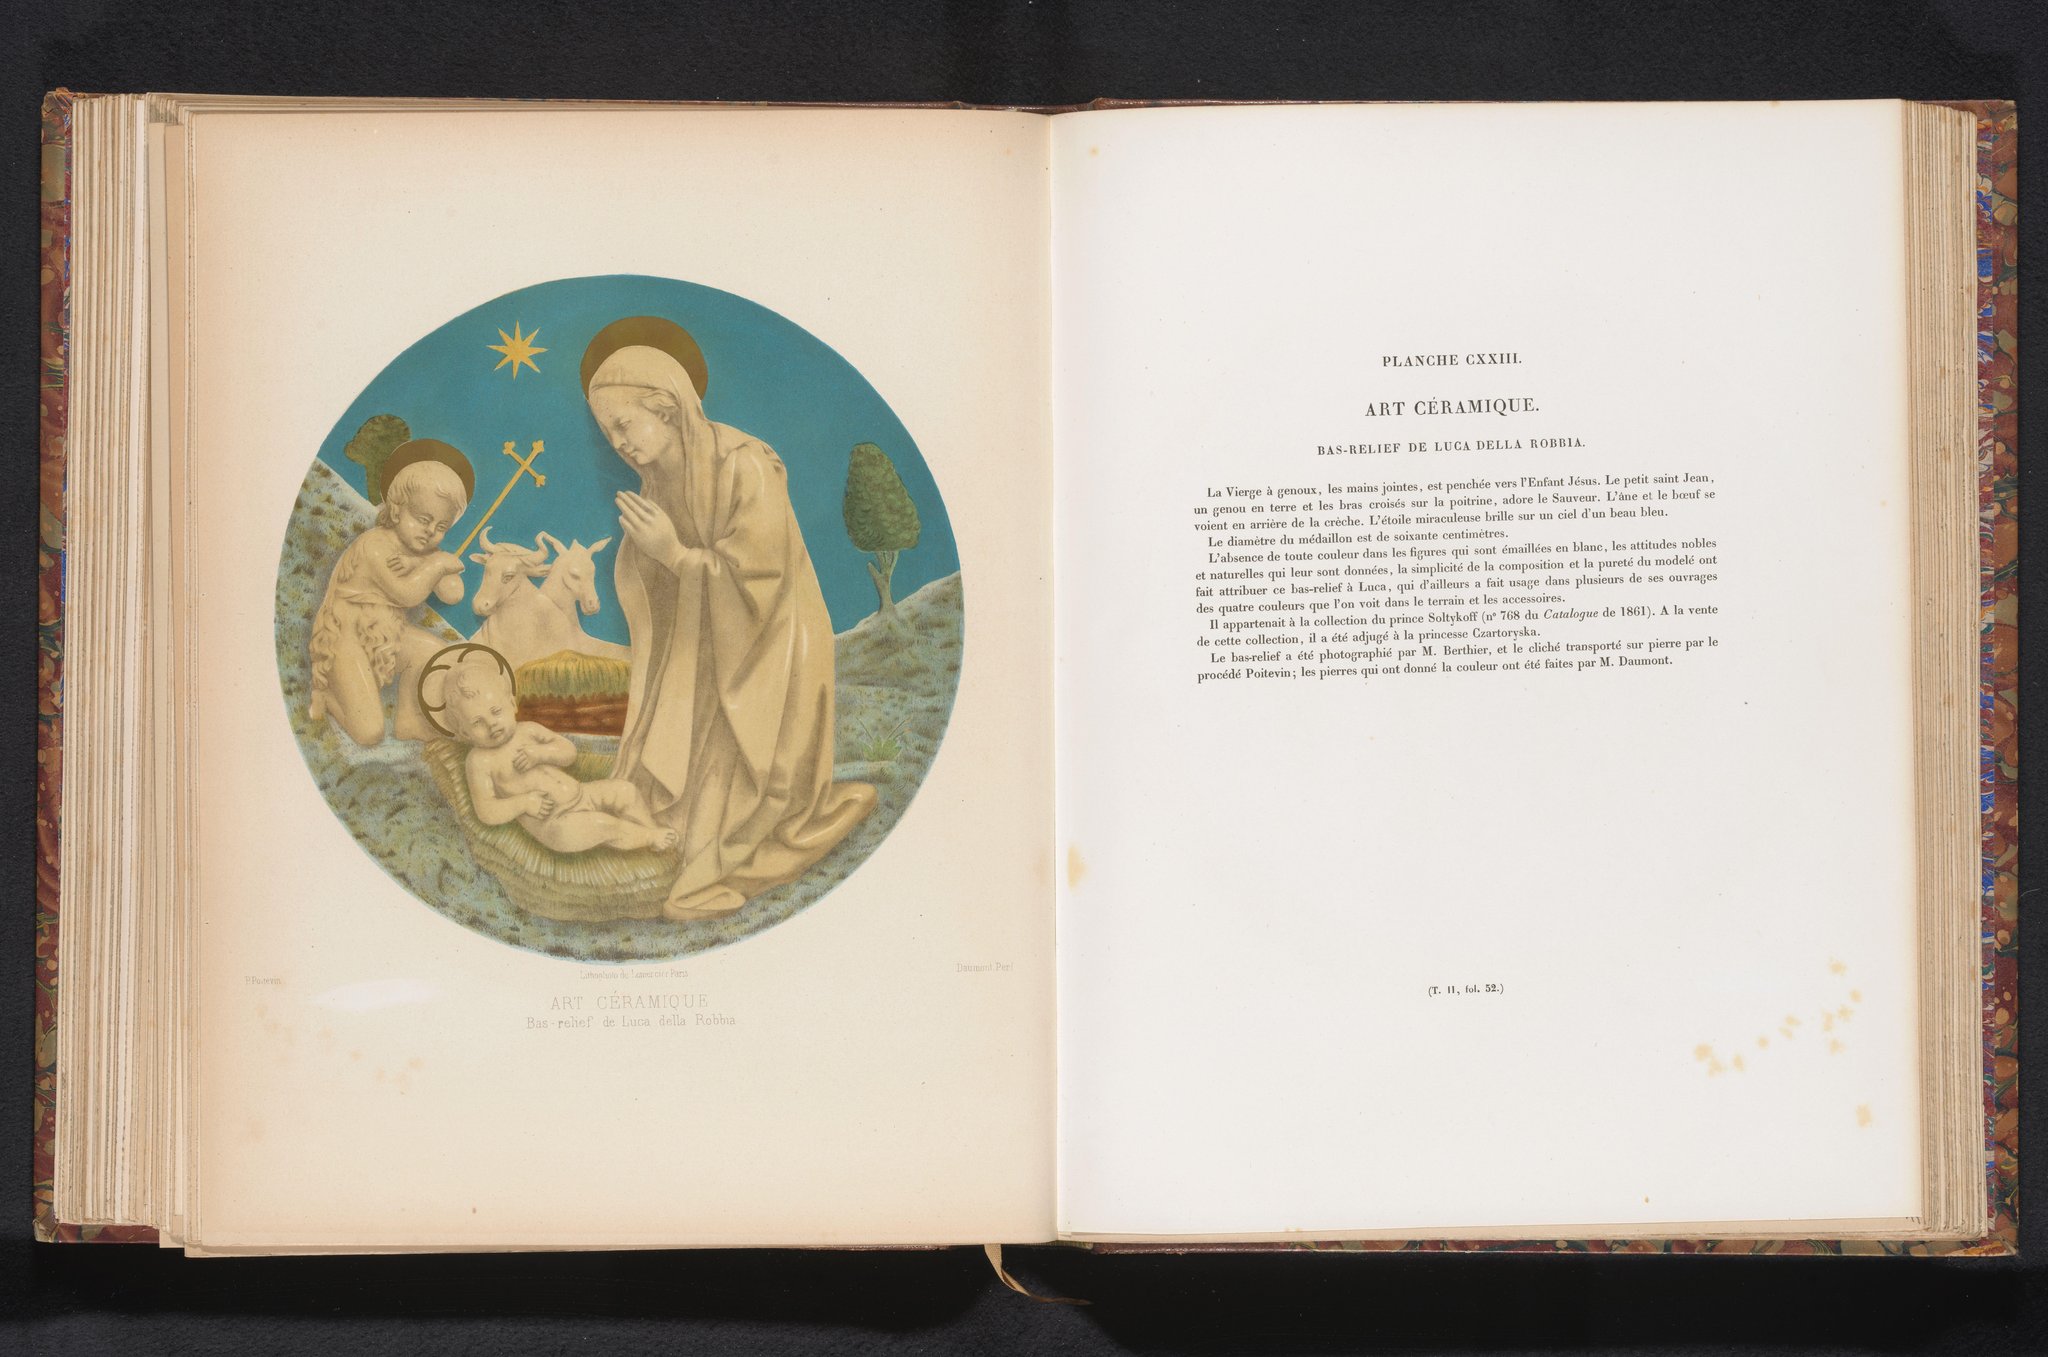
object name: photomechanical print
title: Reproductie van een ontwerp met Maria op haar knieën naast Christus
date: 1859-1864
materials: paper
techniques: photolithography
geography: paris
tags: christ-child ~ types of adult christ, mary kneeling (on the ground), the christ-child in front of her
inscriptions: name: ‘P. Poitevin./ Daumont Perf’